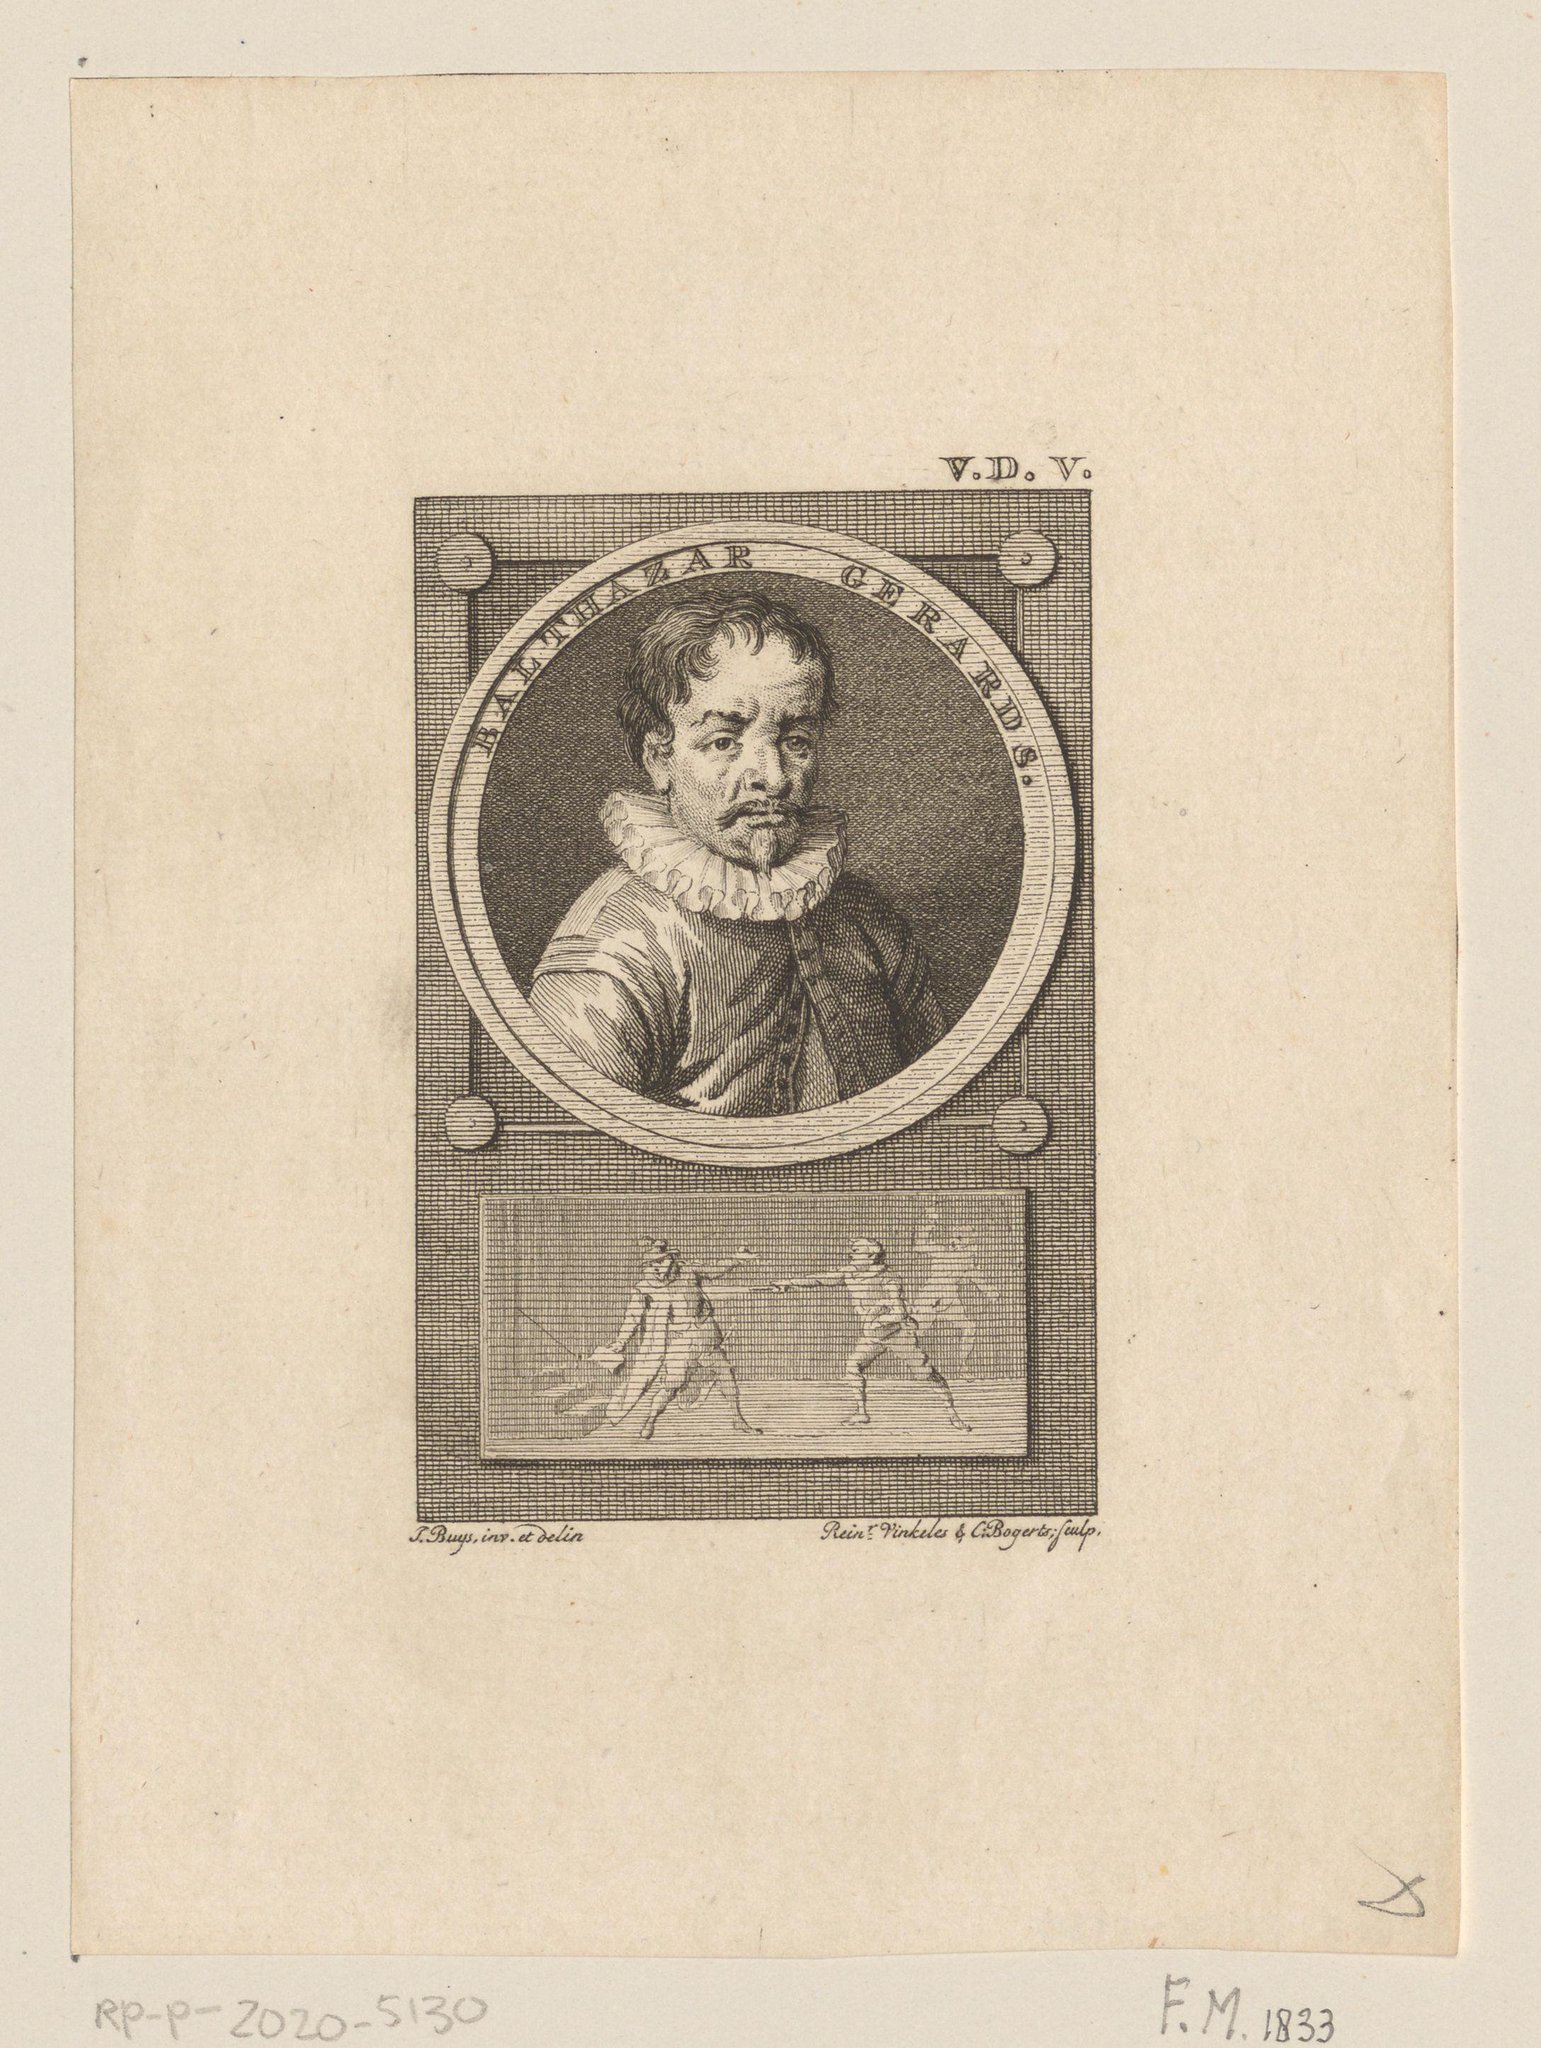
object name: print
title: Portret van Balthasar Gerards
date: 1755-1816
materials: paper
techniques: engraving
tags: delft, historical persons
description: Duel in de ondermarge, waarschijnlijk de moord op Willem van Oranje door Balthasar Gerards.